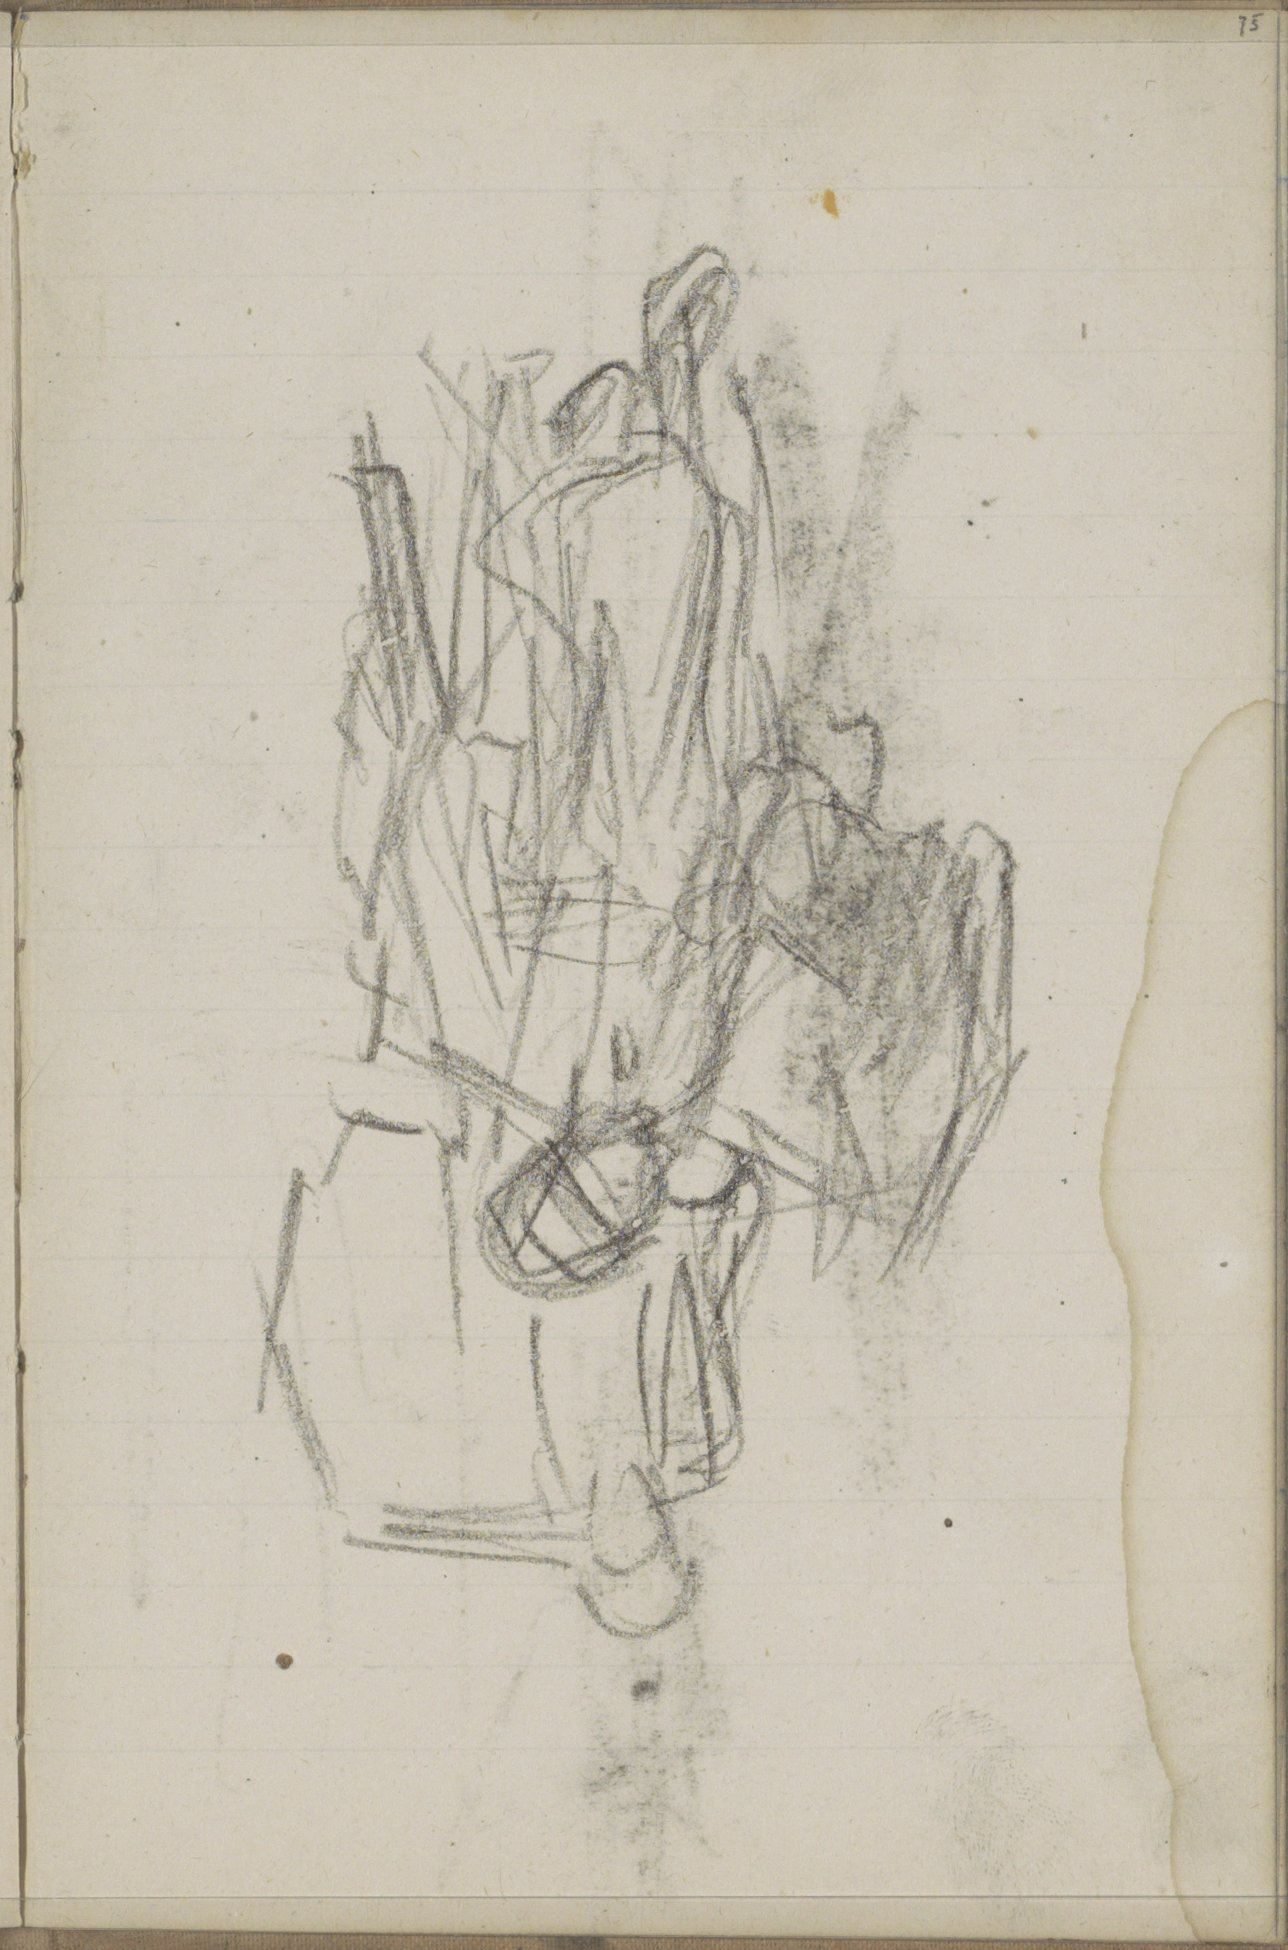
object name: sketchbook leaf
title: Ezel met twee figuren in oosterse kleding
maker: marius bauer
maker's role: draughtsman, print maker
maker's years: 1867-1932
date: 1888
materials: chalk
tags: riding a horse, ass, or mule; rider, horseman, asiatic races and peoples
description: Pagina 75 uit een schetsboek met 49 bladen.